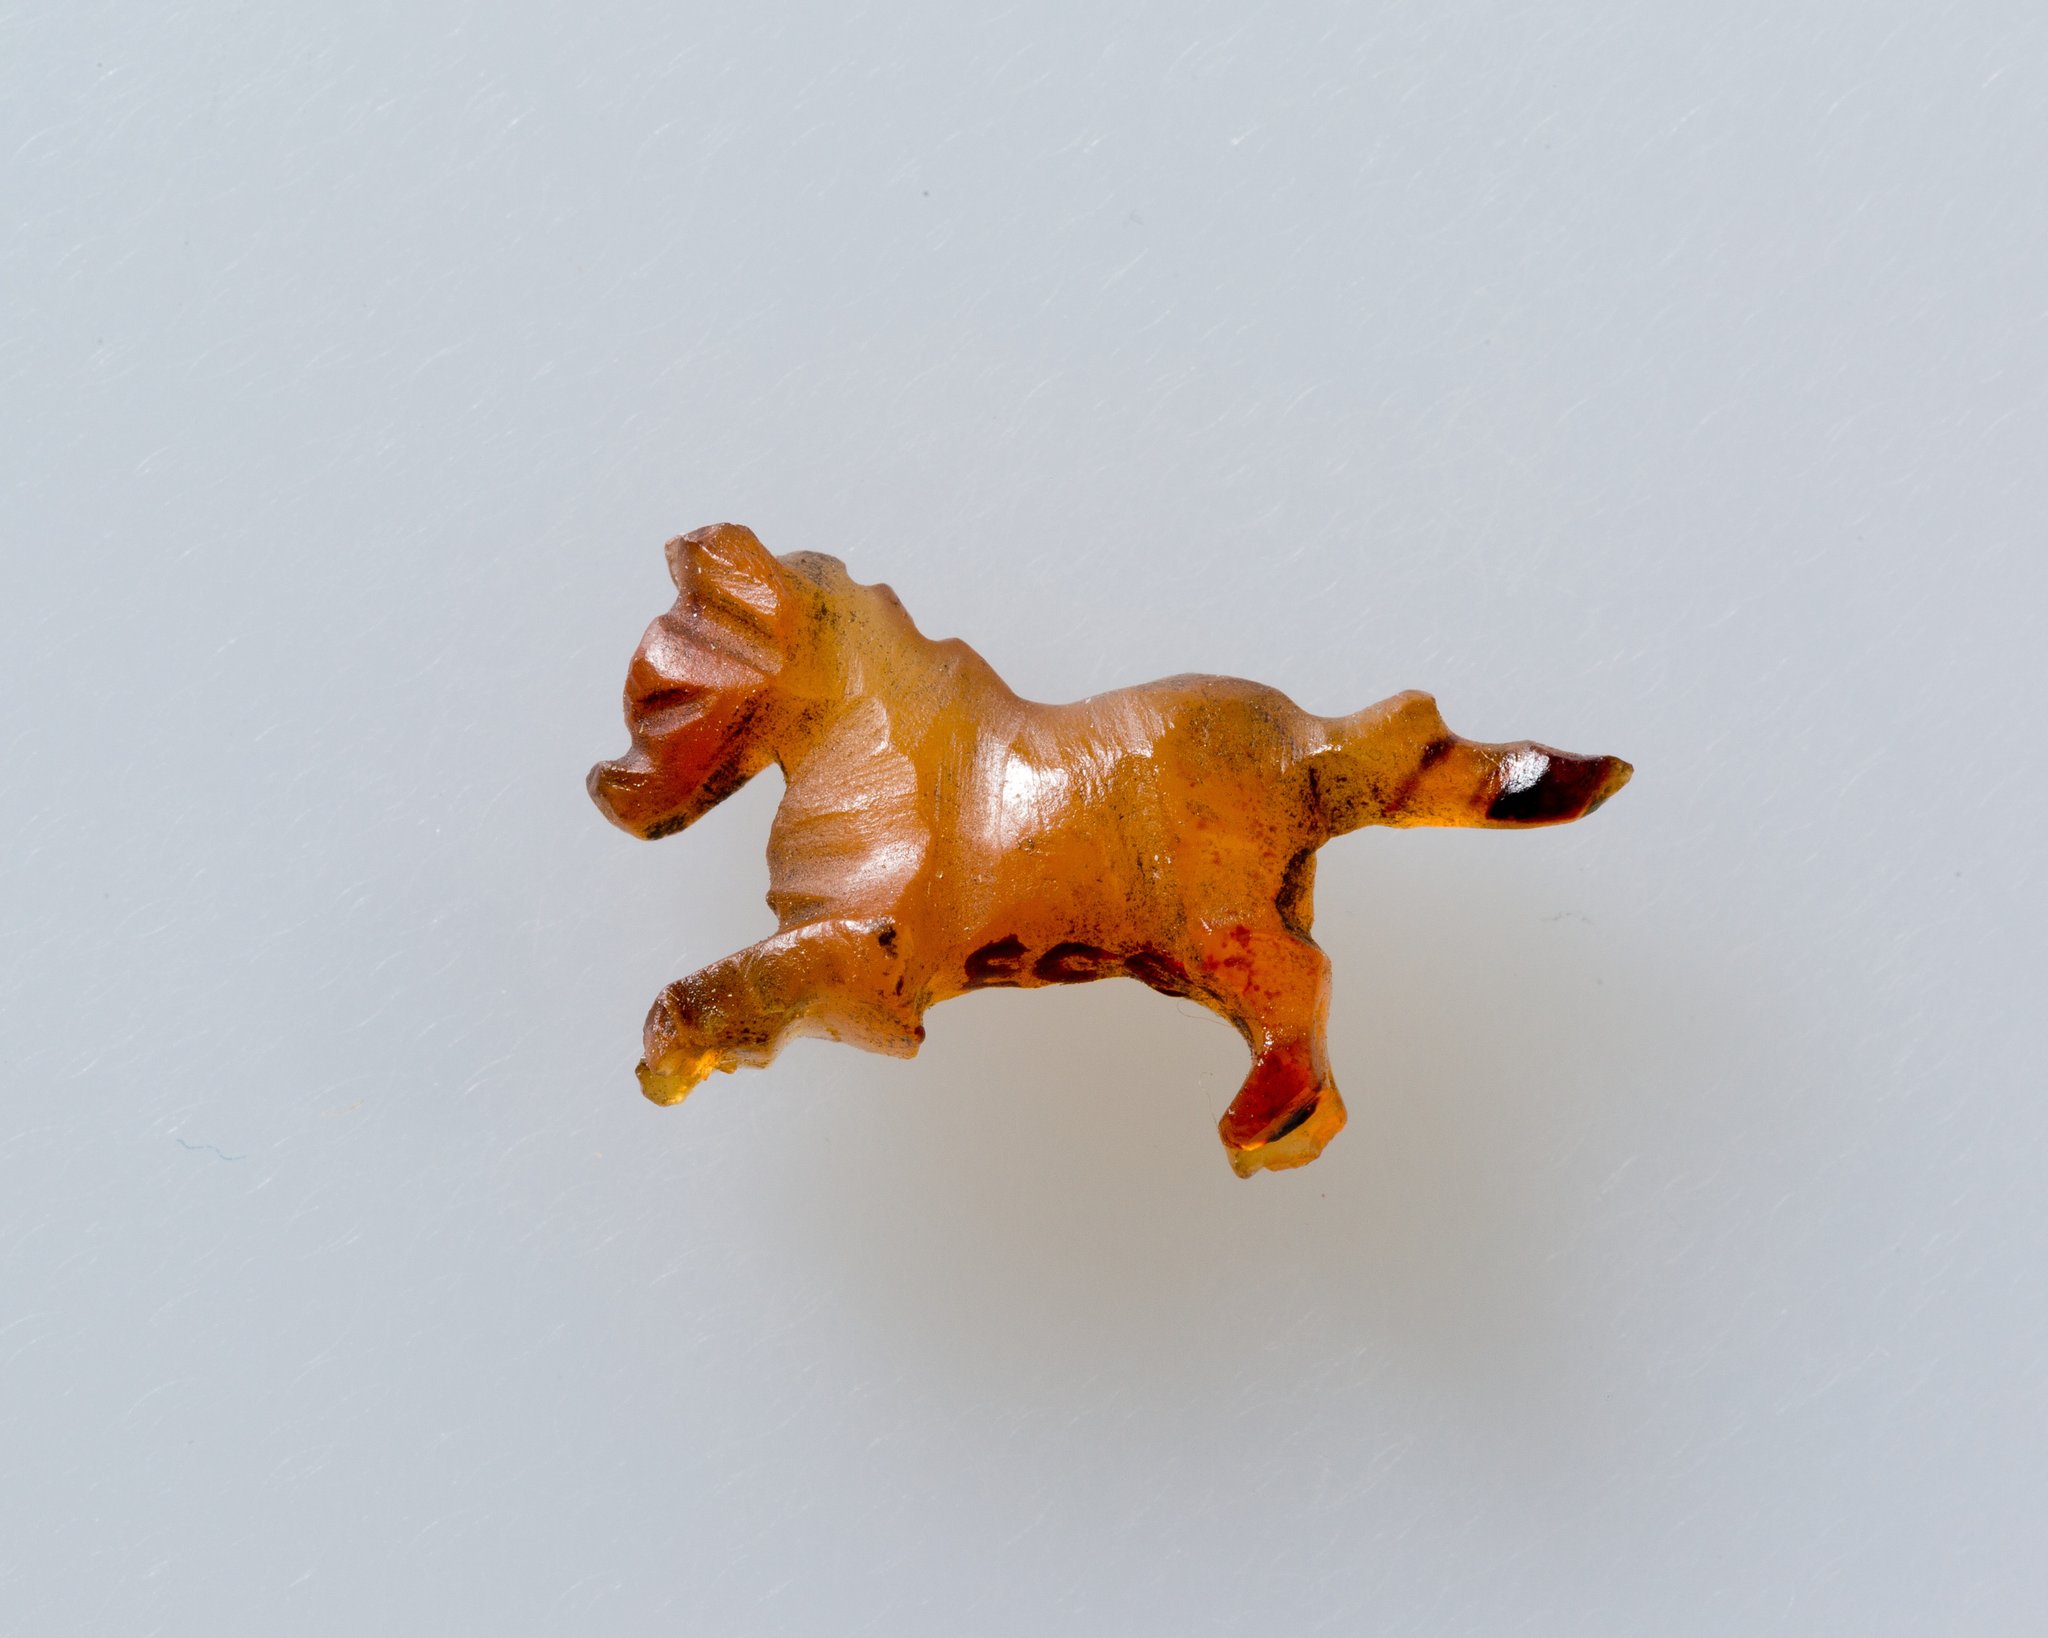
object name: amulet, horse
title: Running horse amulet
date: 200 BCE-200 CE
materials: gemstone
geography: egypt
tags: horses